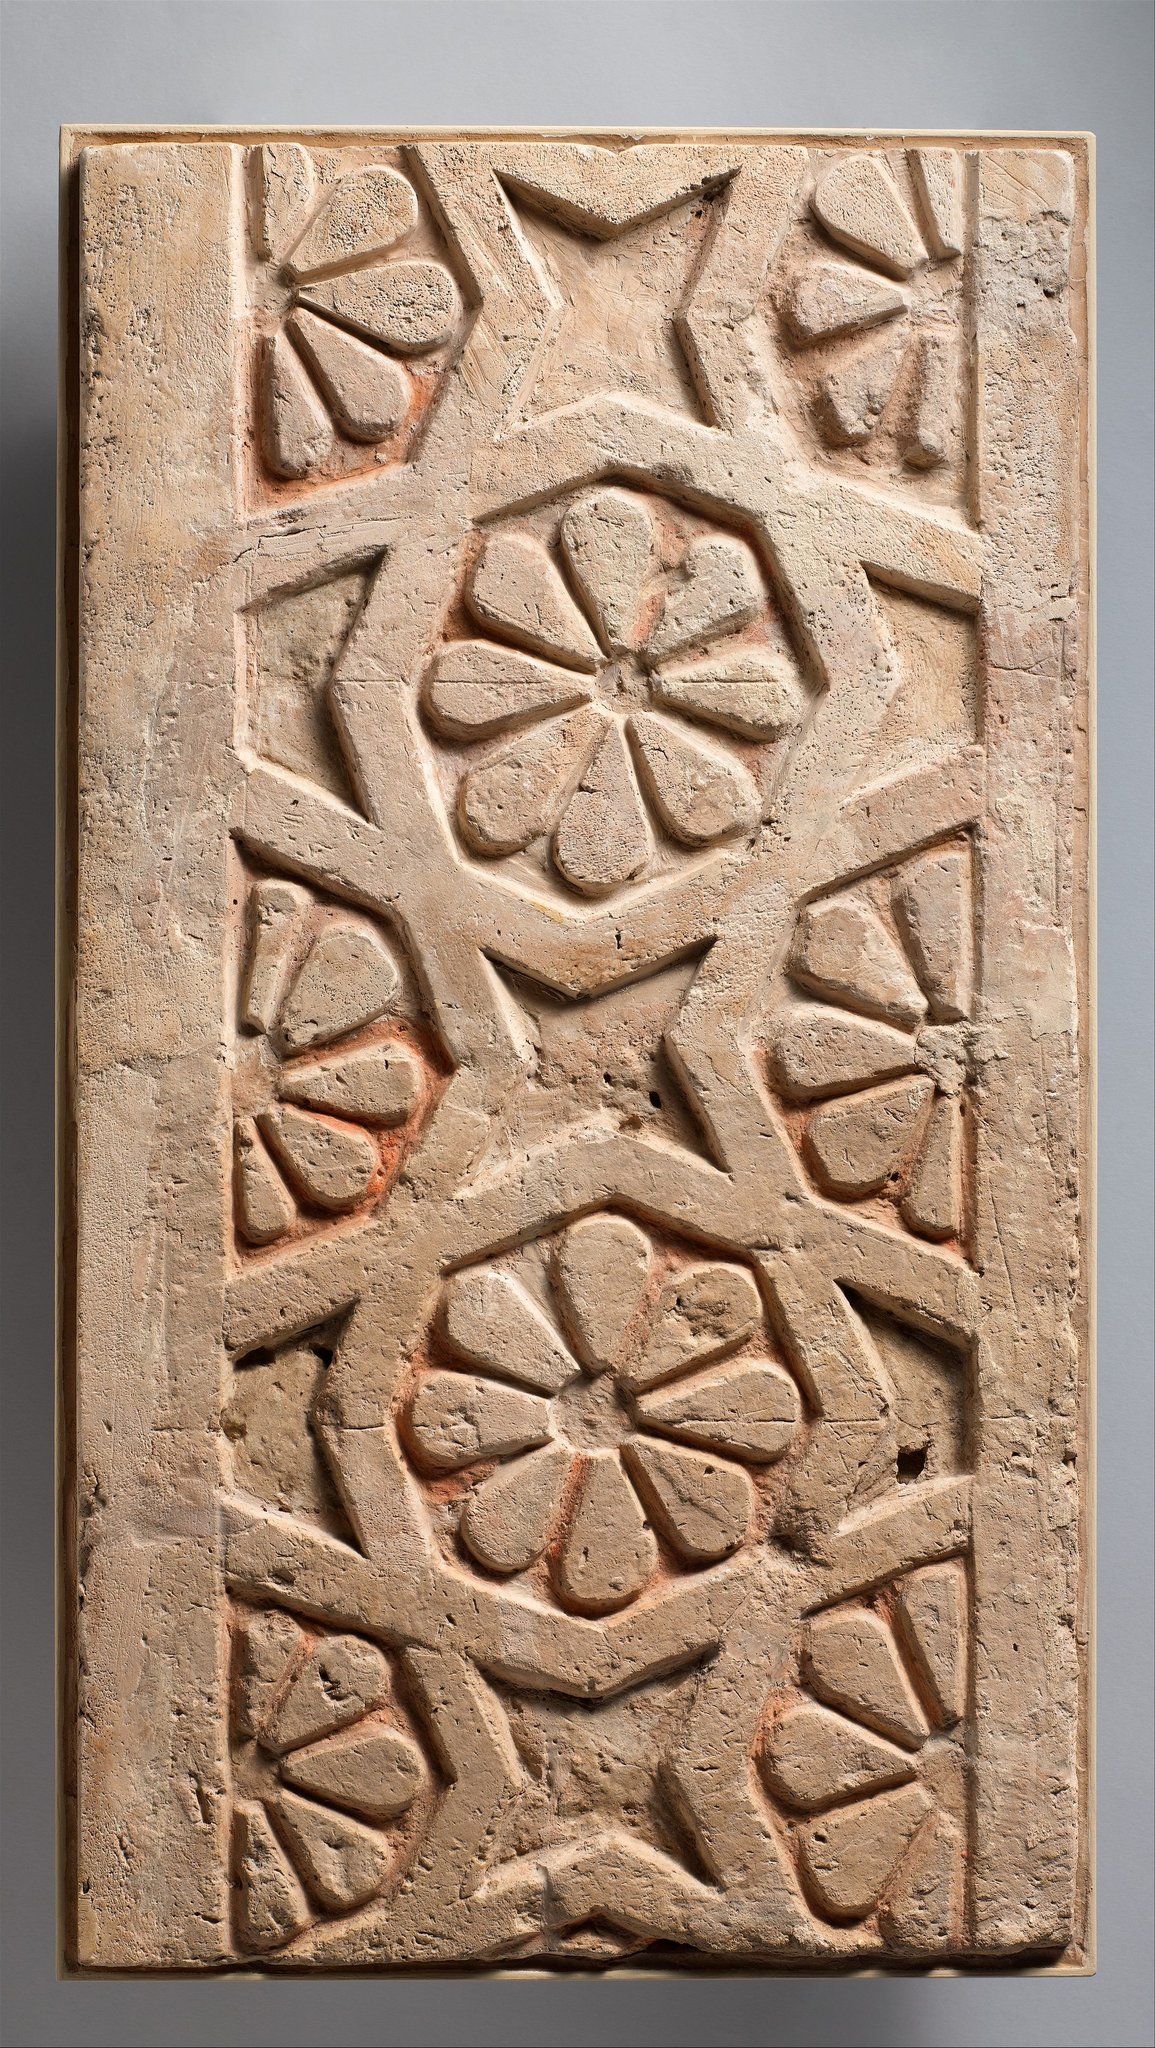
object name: frieze fragment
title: Fragment of a Frieze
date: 1001-1100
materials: terracotta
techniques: carving, painting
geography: iran